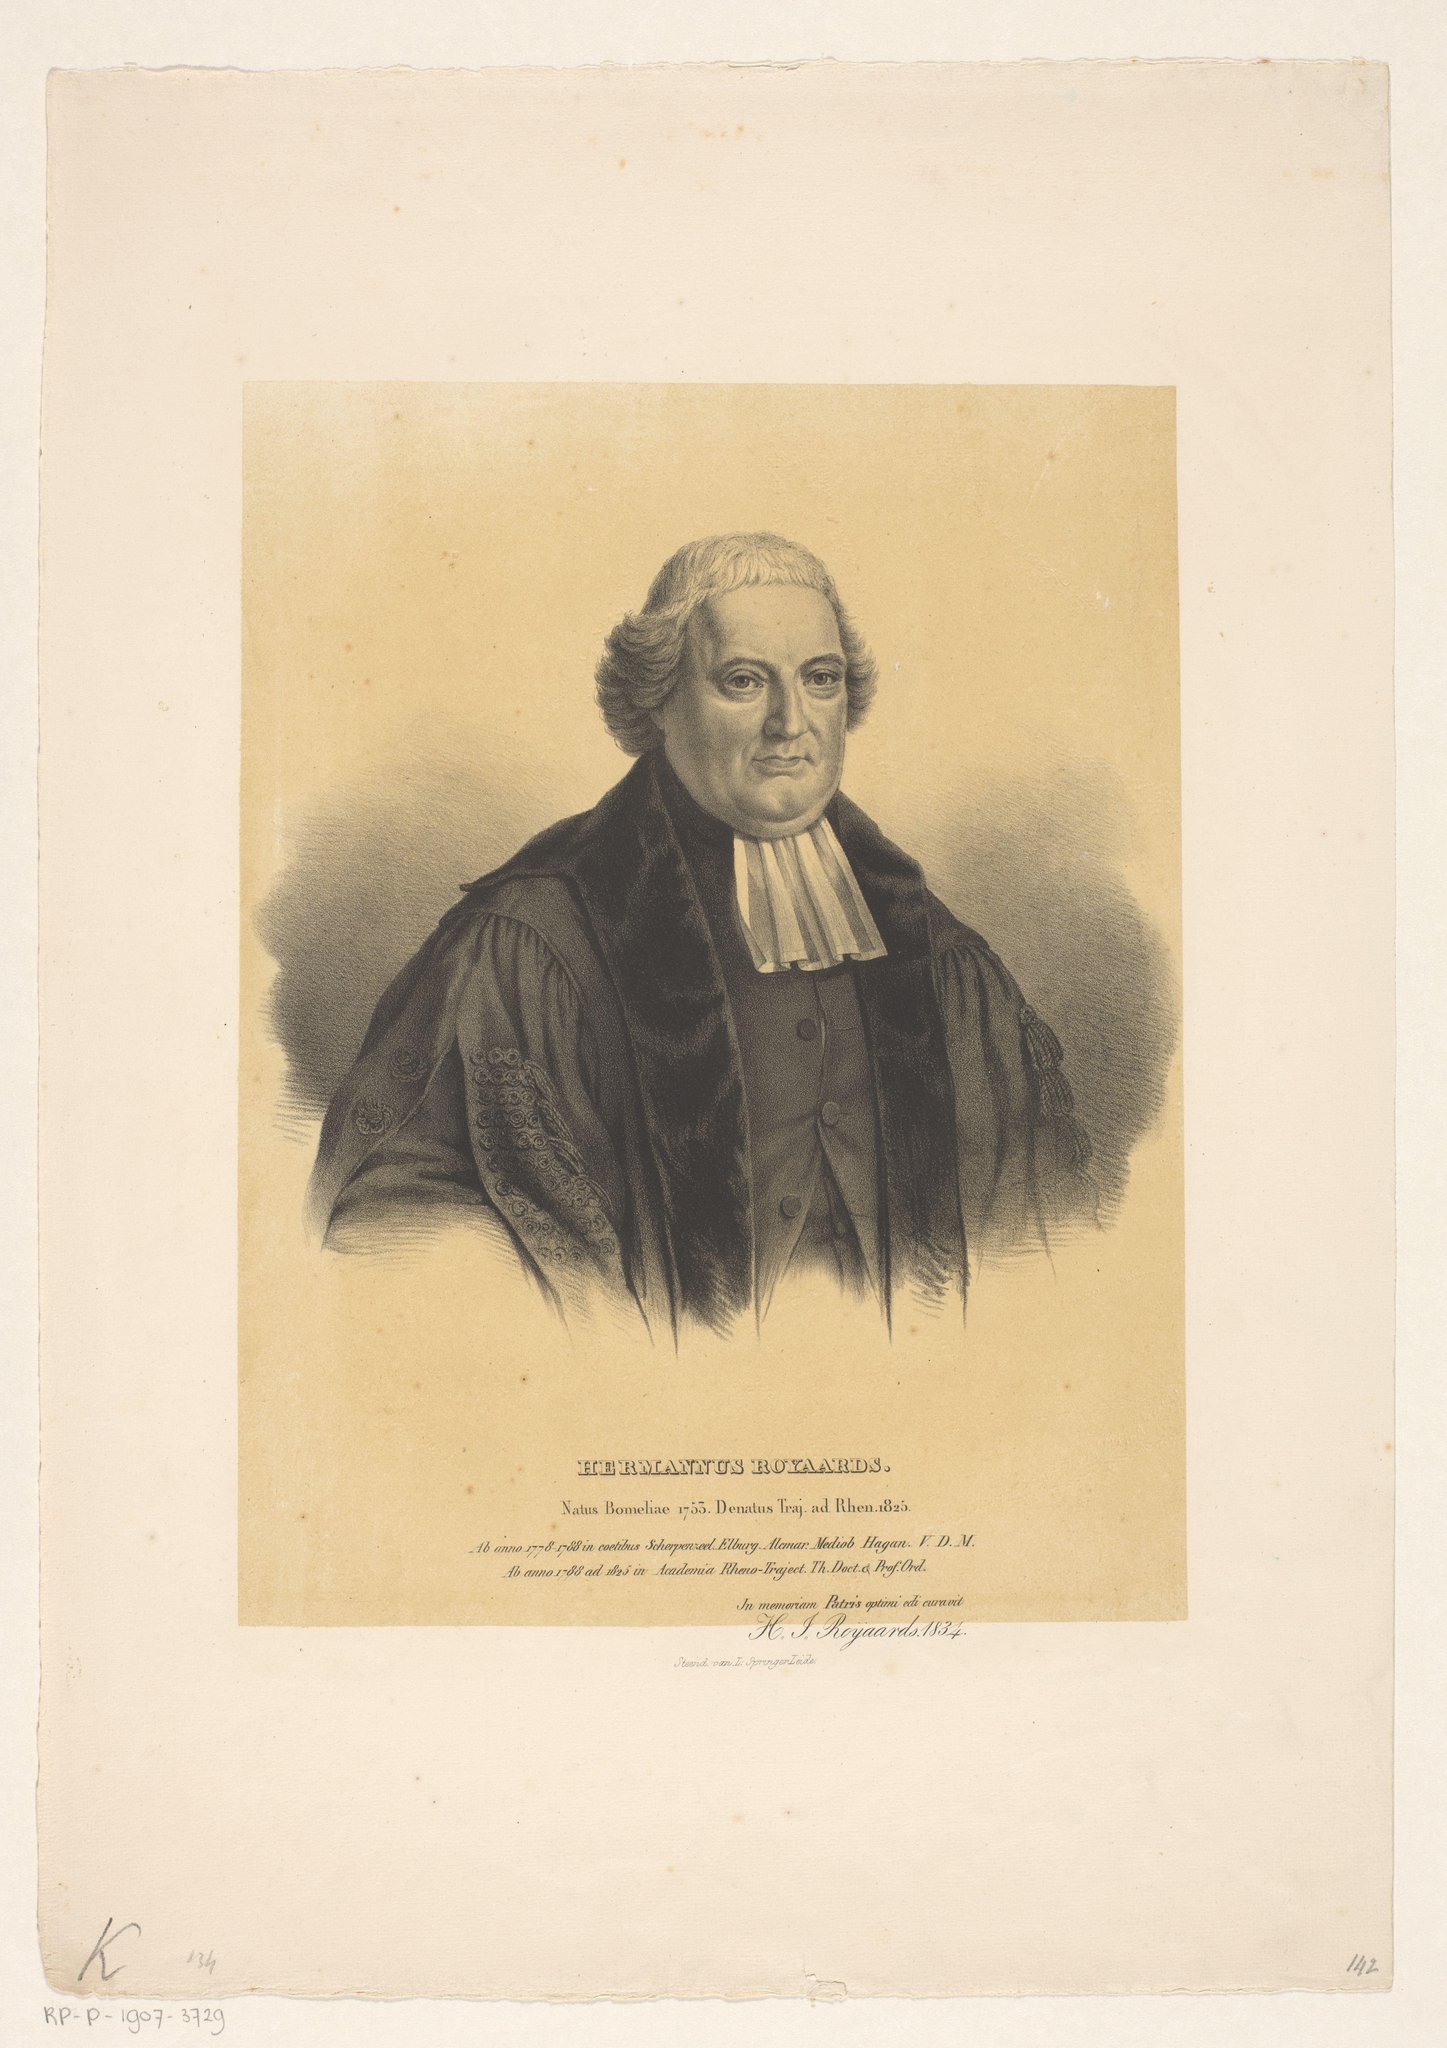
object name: print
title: Portret van Hermannus Royaards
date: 1834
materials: paper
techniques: tone lithography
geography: leiden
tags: utrecht, historical persons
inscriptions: collector's mark: Lugt 2228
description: Onder het portret de biografische gegevens van de geportretteerde.